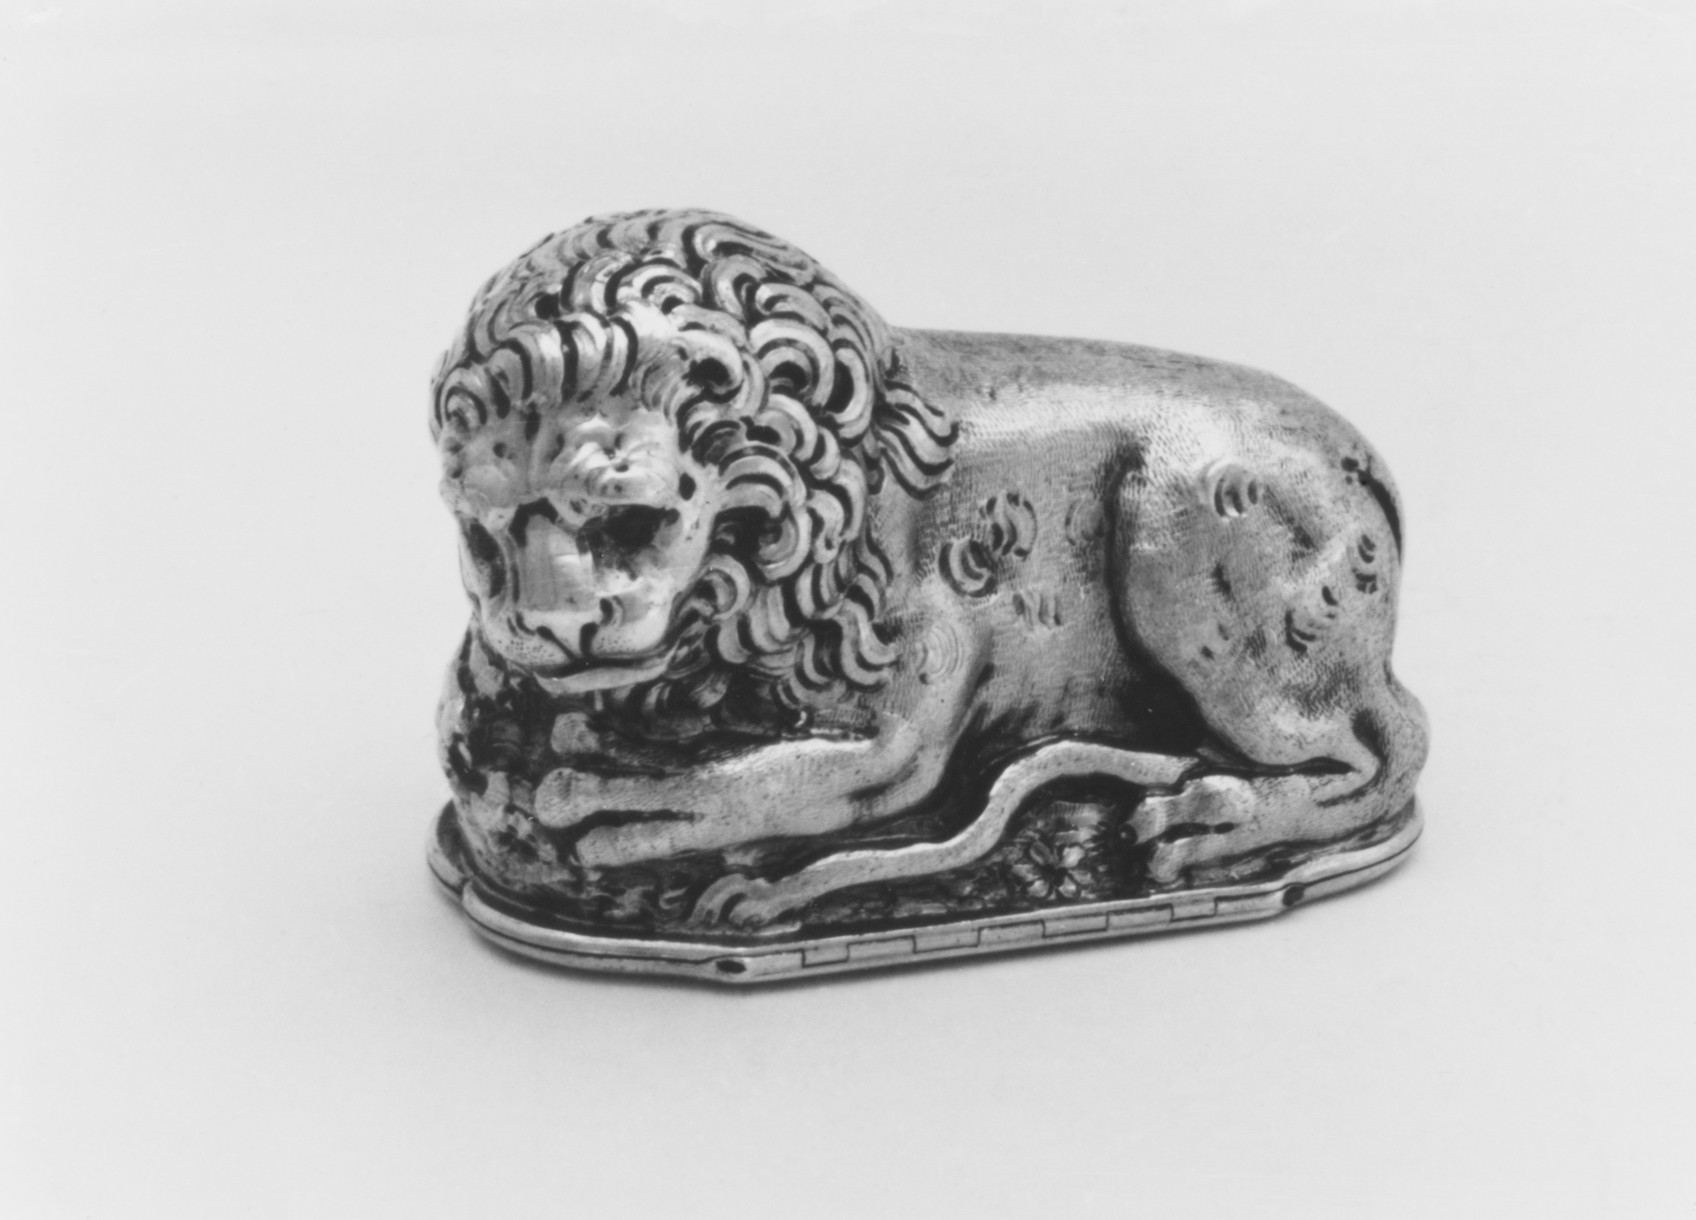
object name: snuffbox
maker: j.p.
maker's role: maker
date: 1736-1737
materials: silver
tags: lions